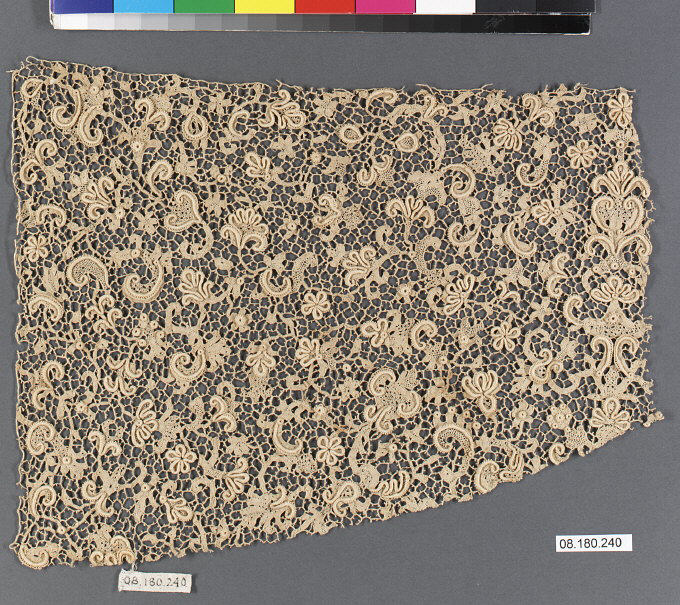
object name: fragment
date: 1701-1733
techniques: lace